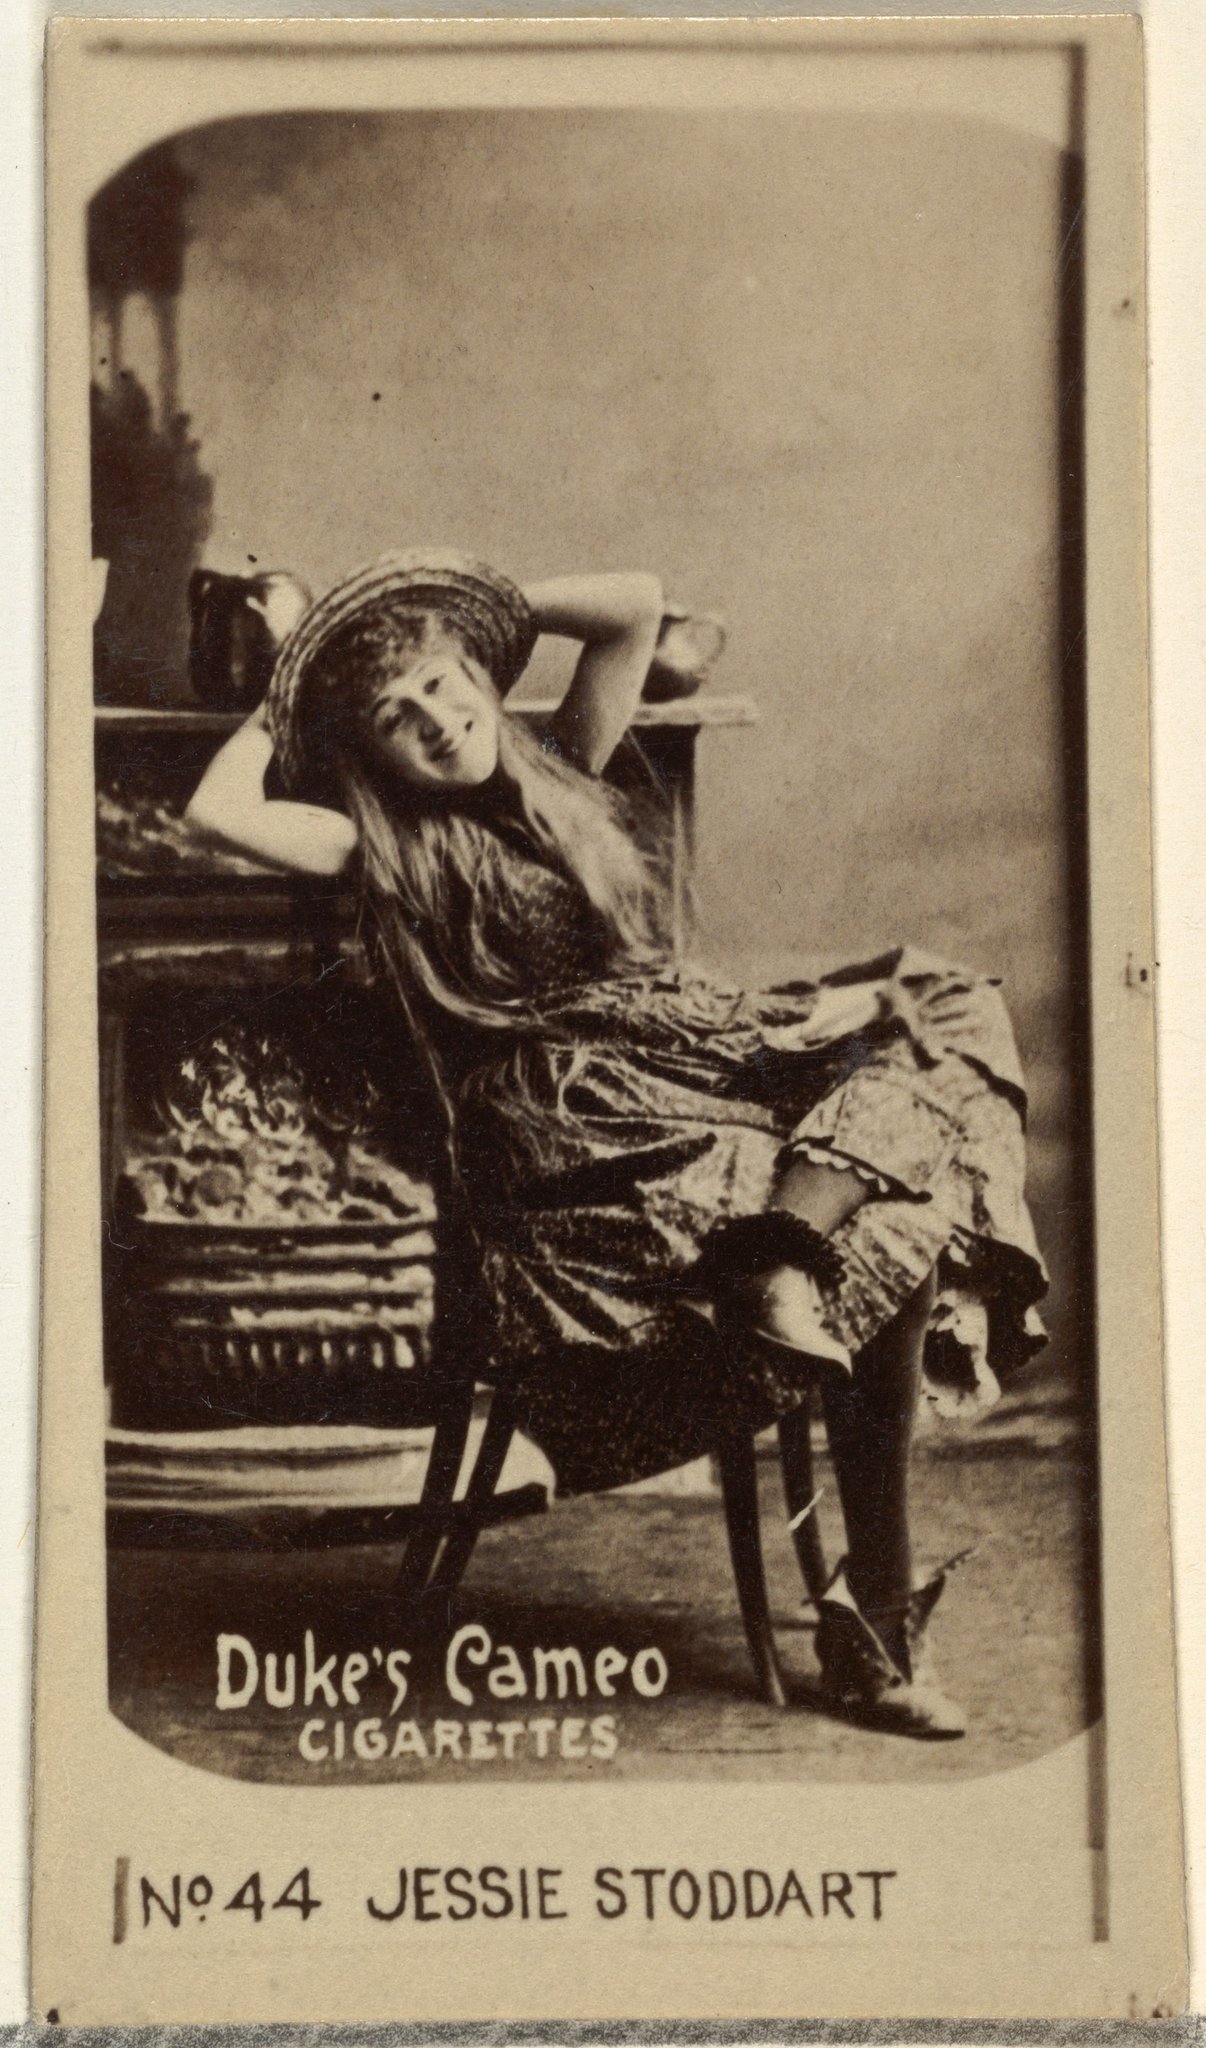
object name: photograph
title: Card Number 44, Jessie Stoddart, from the Actors and Actresses series (N145-4) issued by Duke Sons & Co. to promote Cameo Cigarettes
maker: w. duke, sons & co.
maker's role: publisher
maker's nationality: american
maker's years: 1870-1920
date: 1880-1889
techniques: albumen silver print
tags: portraits,women,actresses